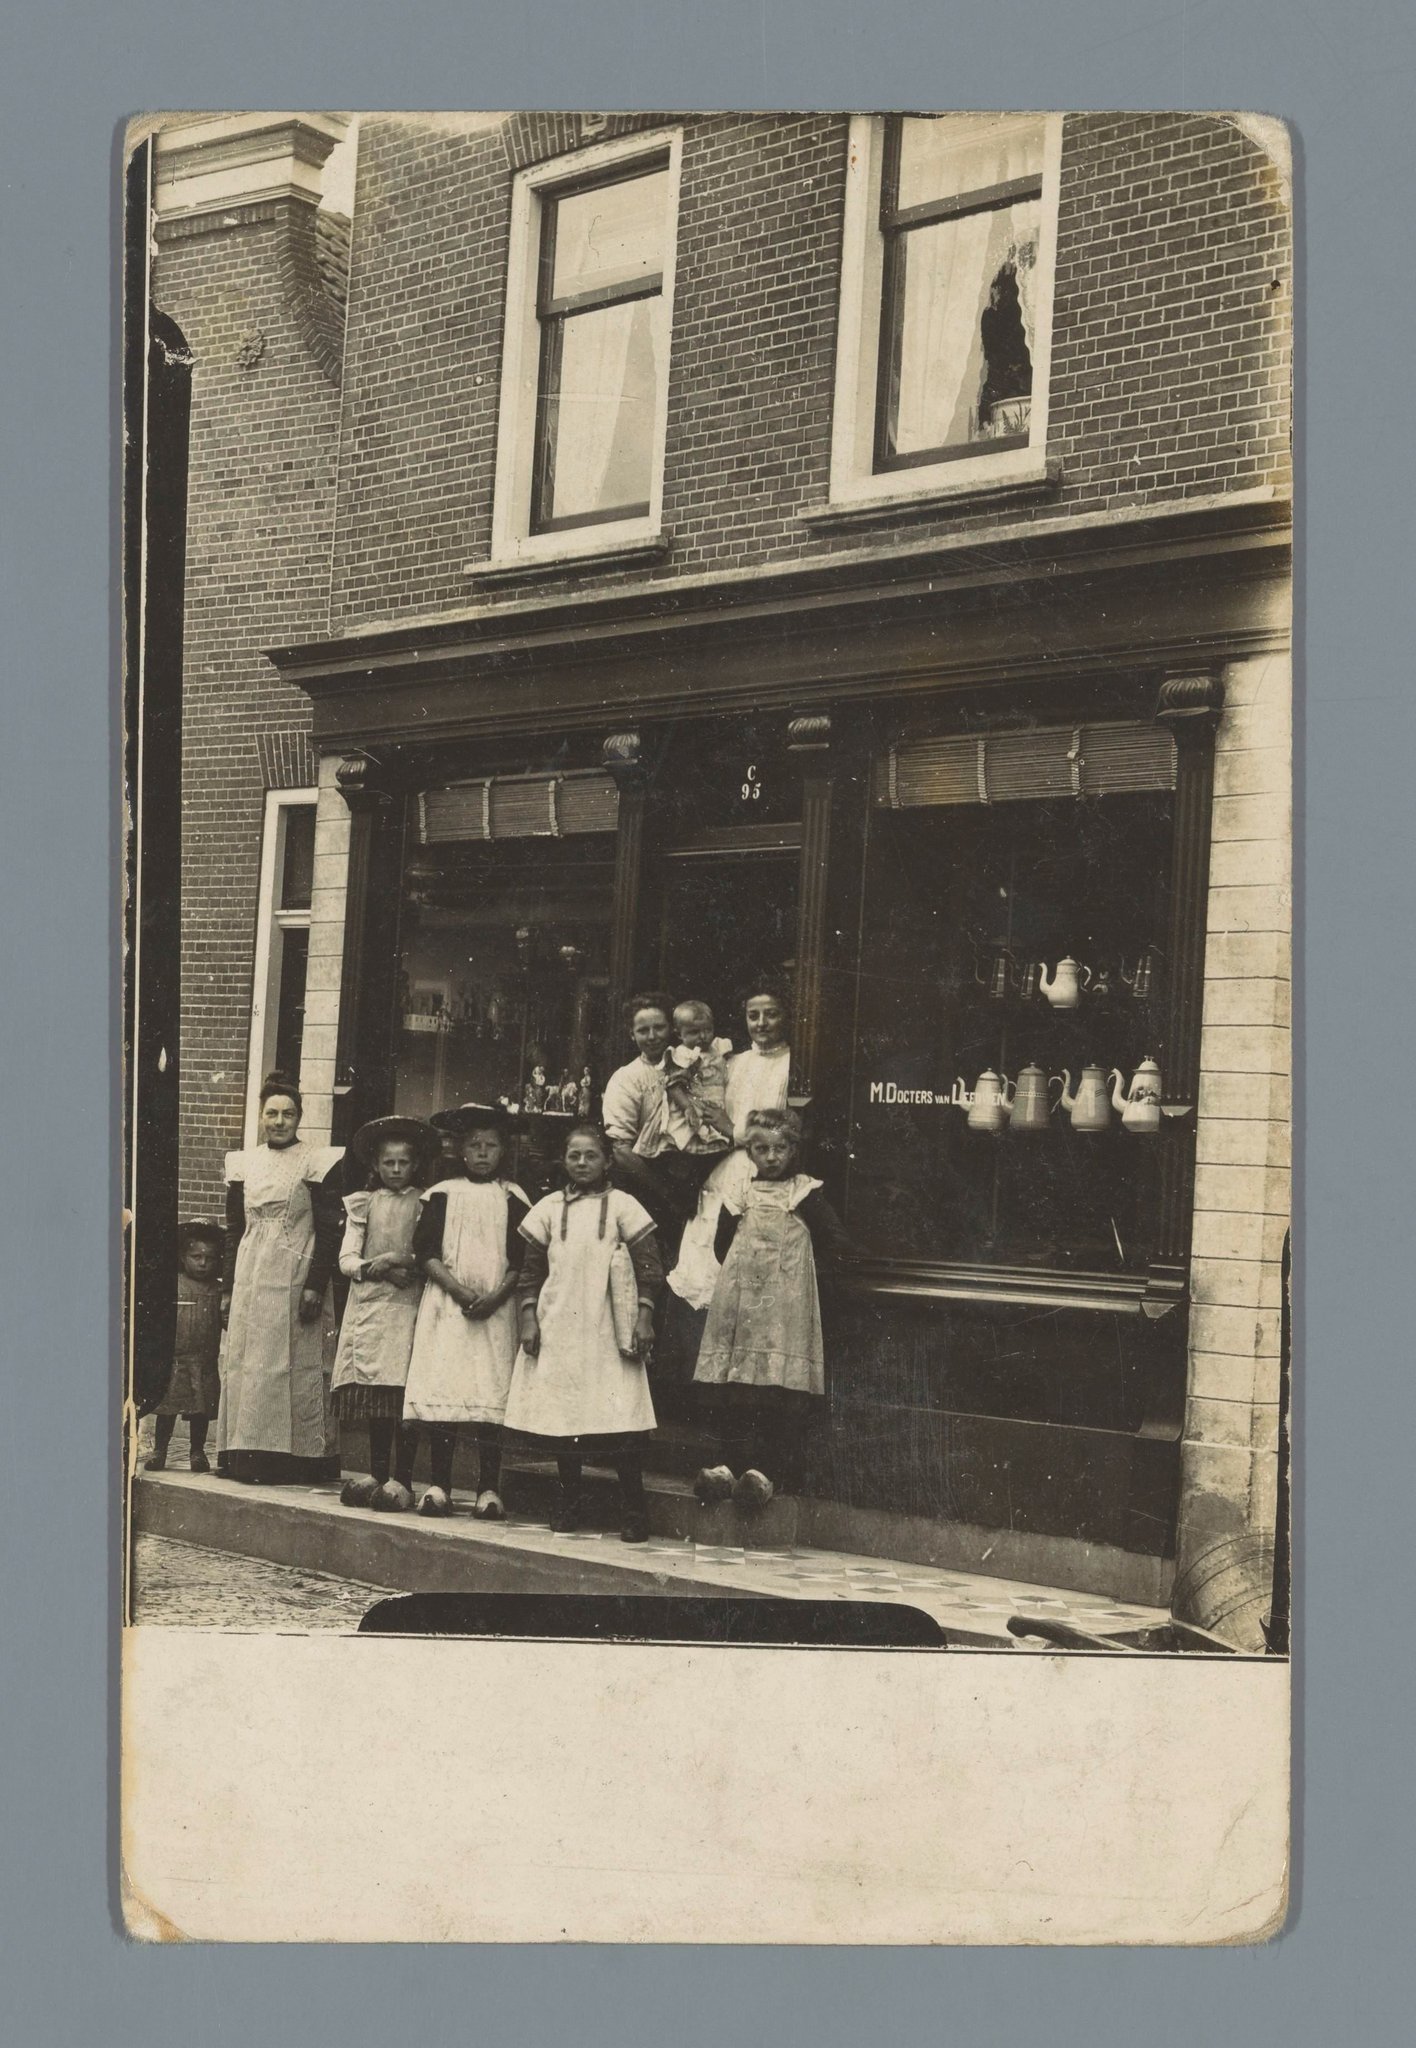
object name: ansichtkaart, prentbriefkaart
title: Groepsportret van onbekende vrouwen en kinderen voor de winkel van M. Docters van Leeuwen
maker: Anonymous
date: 1907-1915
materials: photographic support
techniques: gelatin silver print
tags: shop, store, street, anonymous historical persons portrayed in a group, in a group-portrait